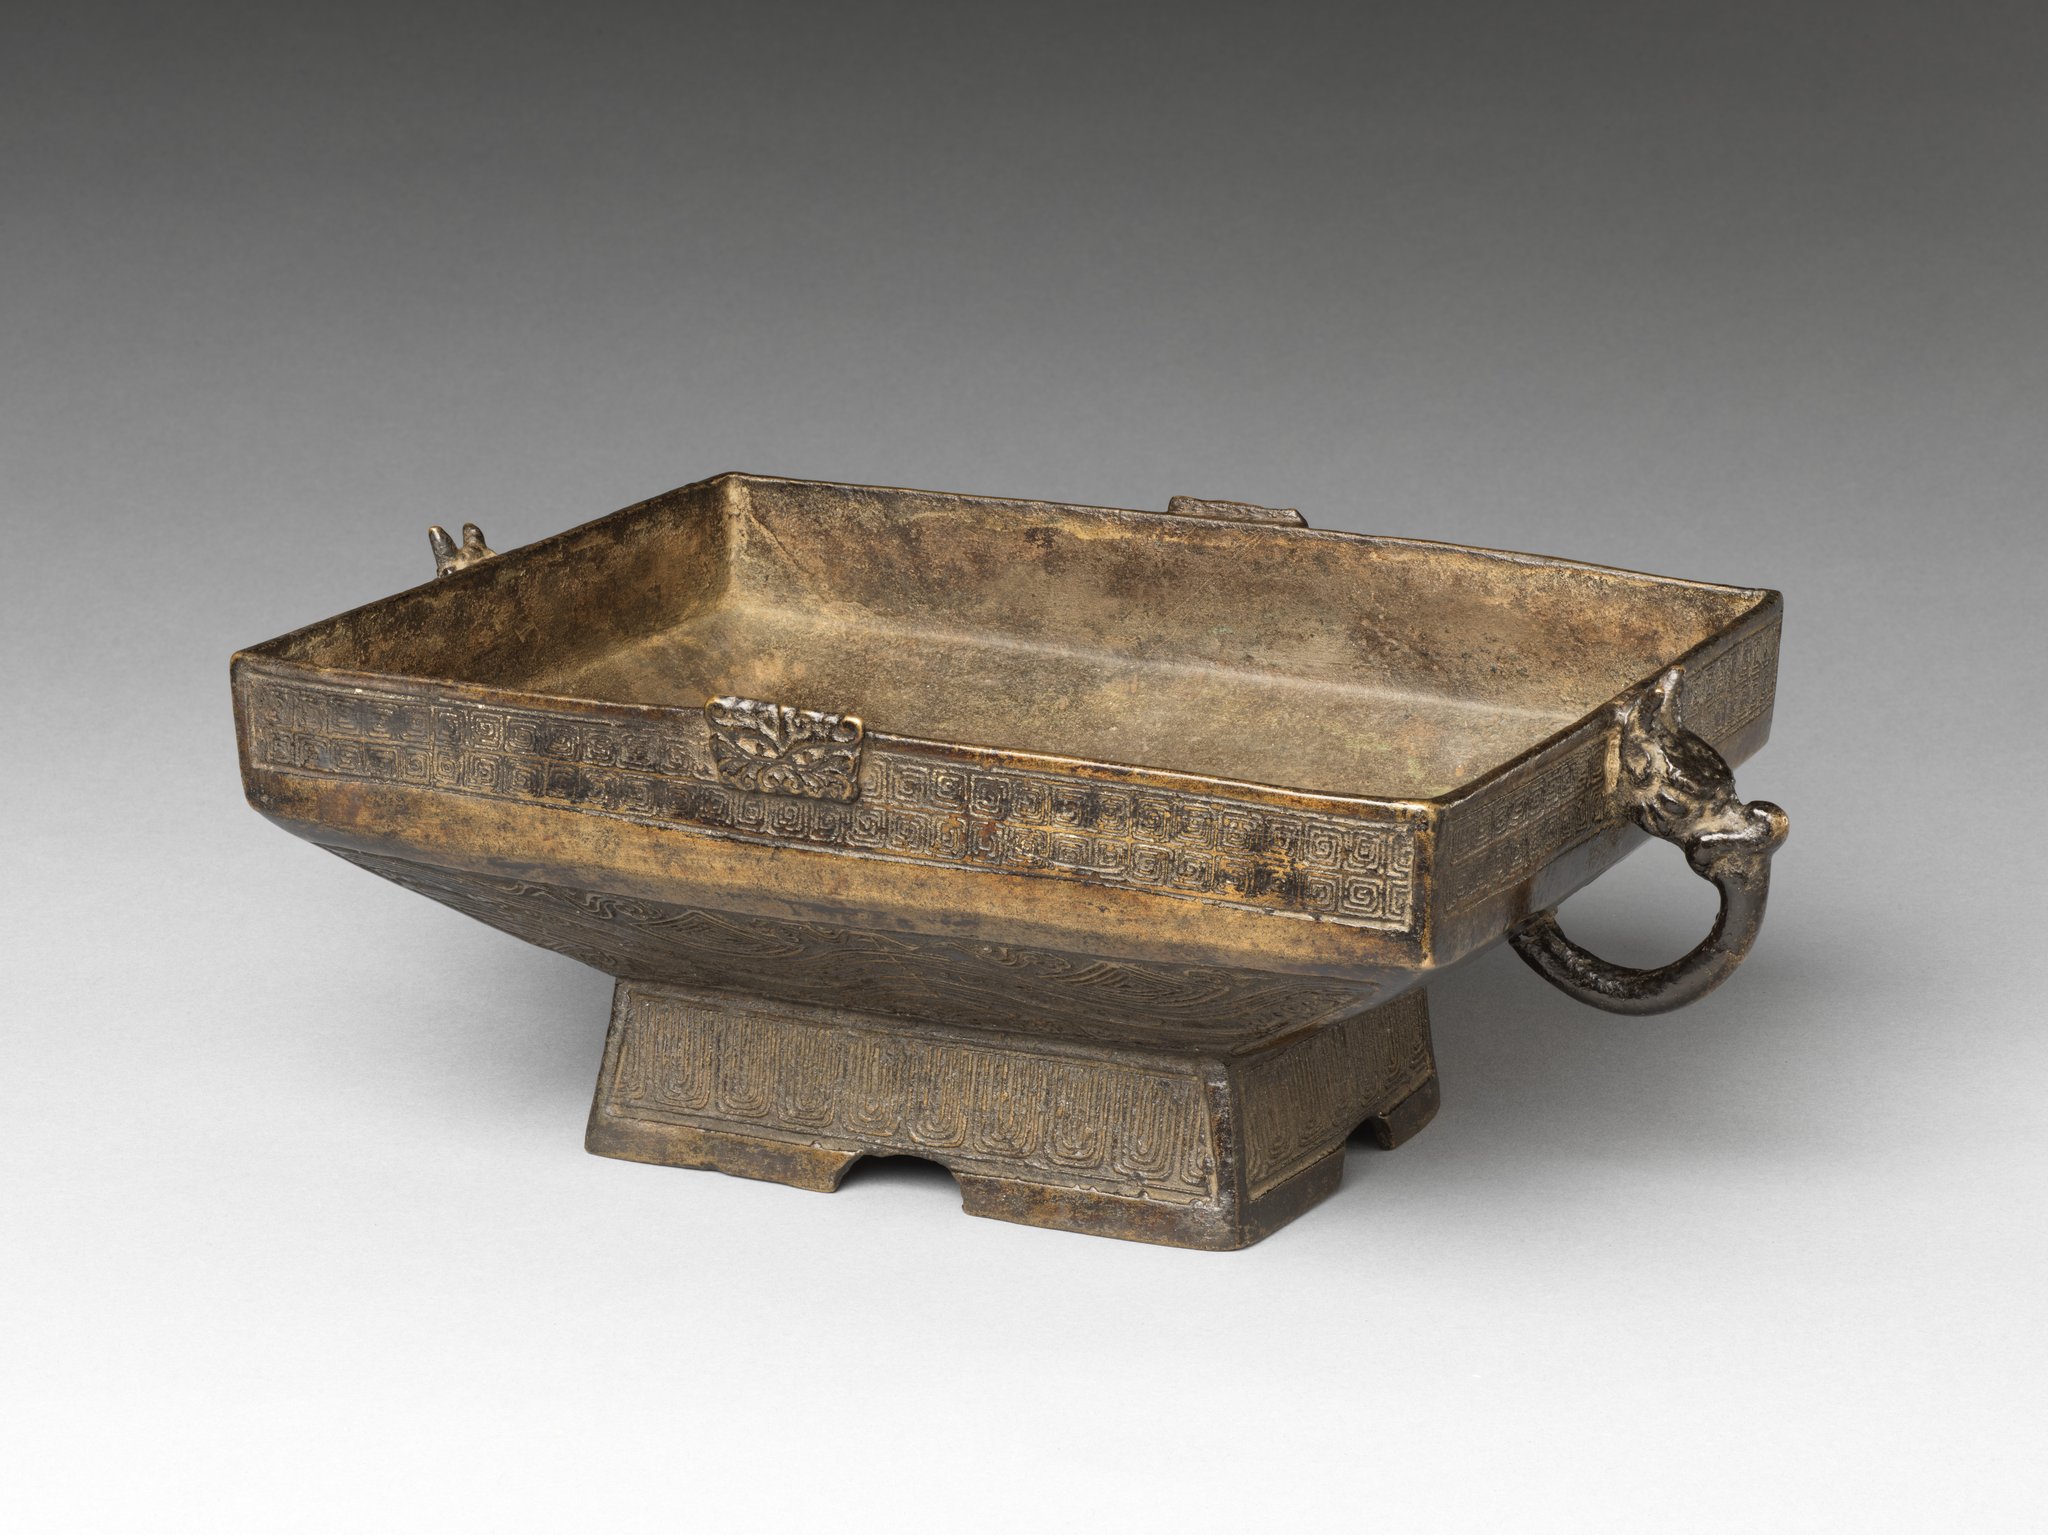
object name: vessel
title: Ritual grain container (fu)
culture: chinese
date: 1321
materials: copper alloy